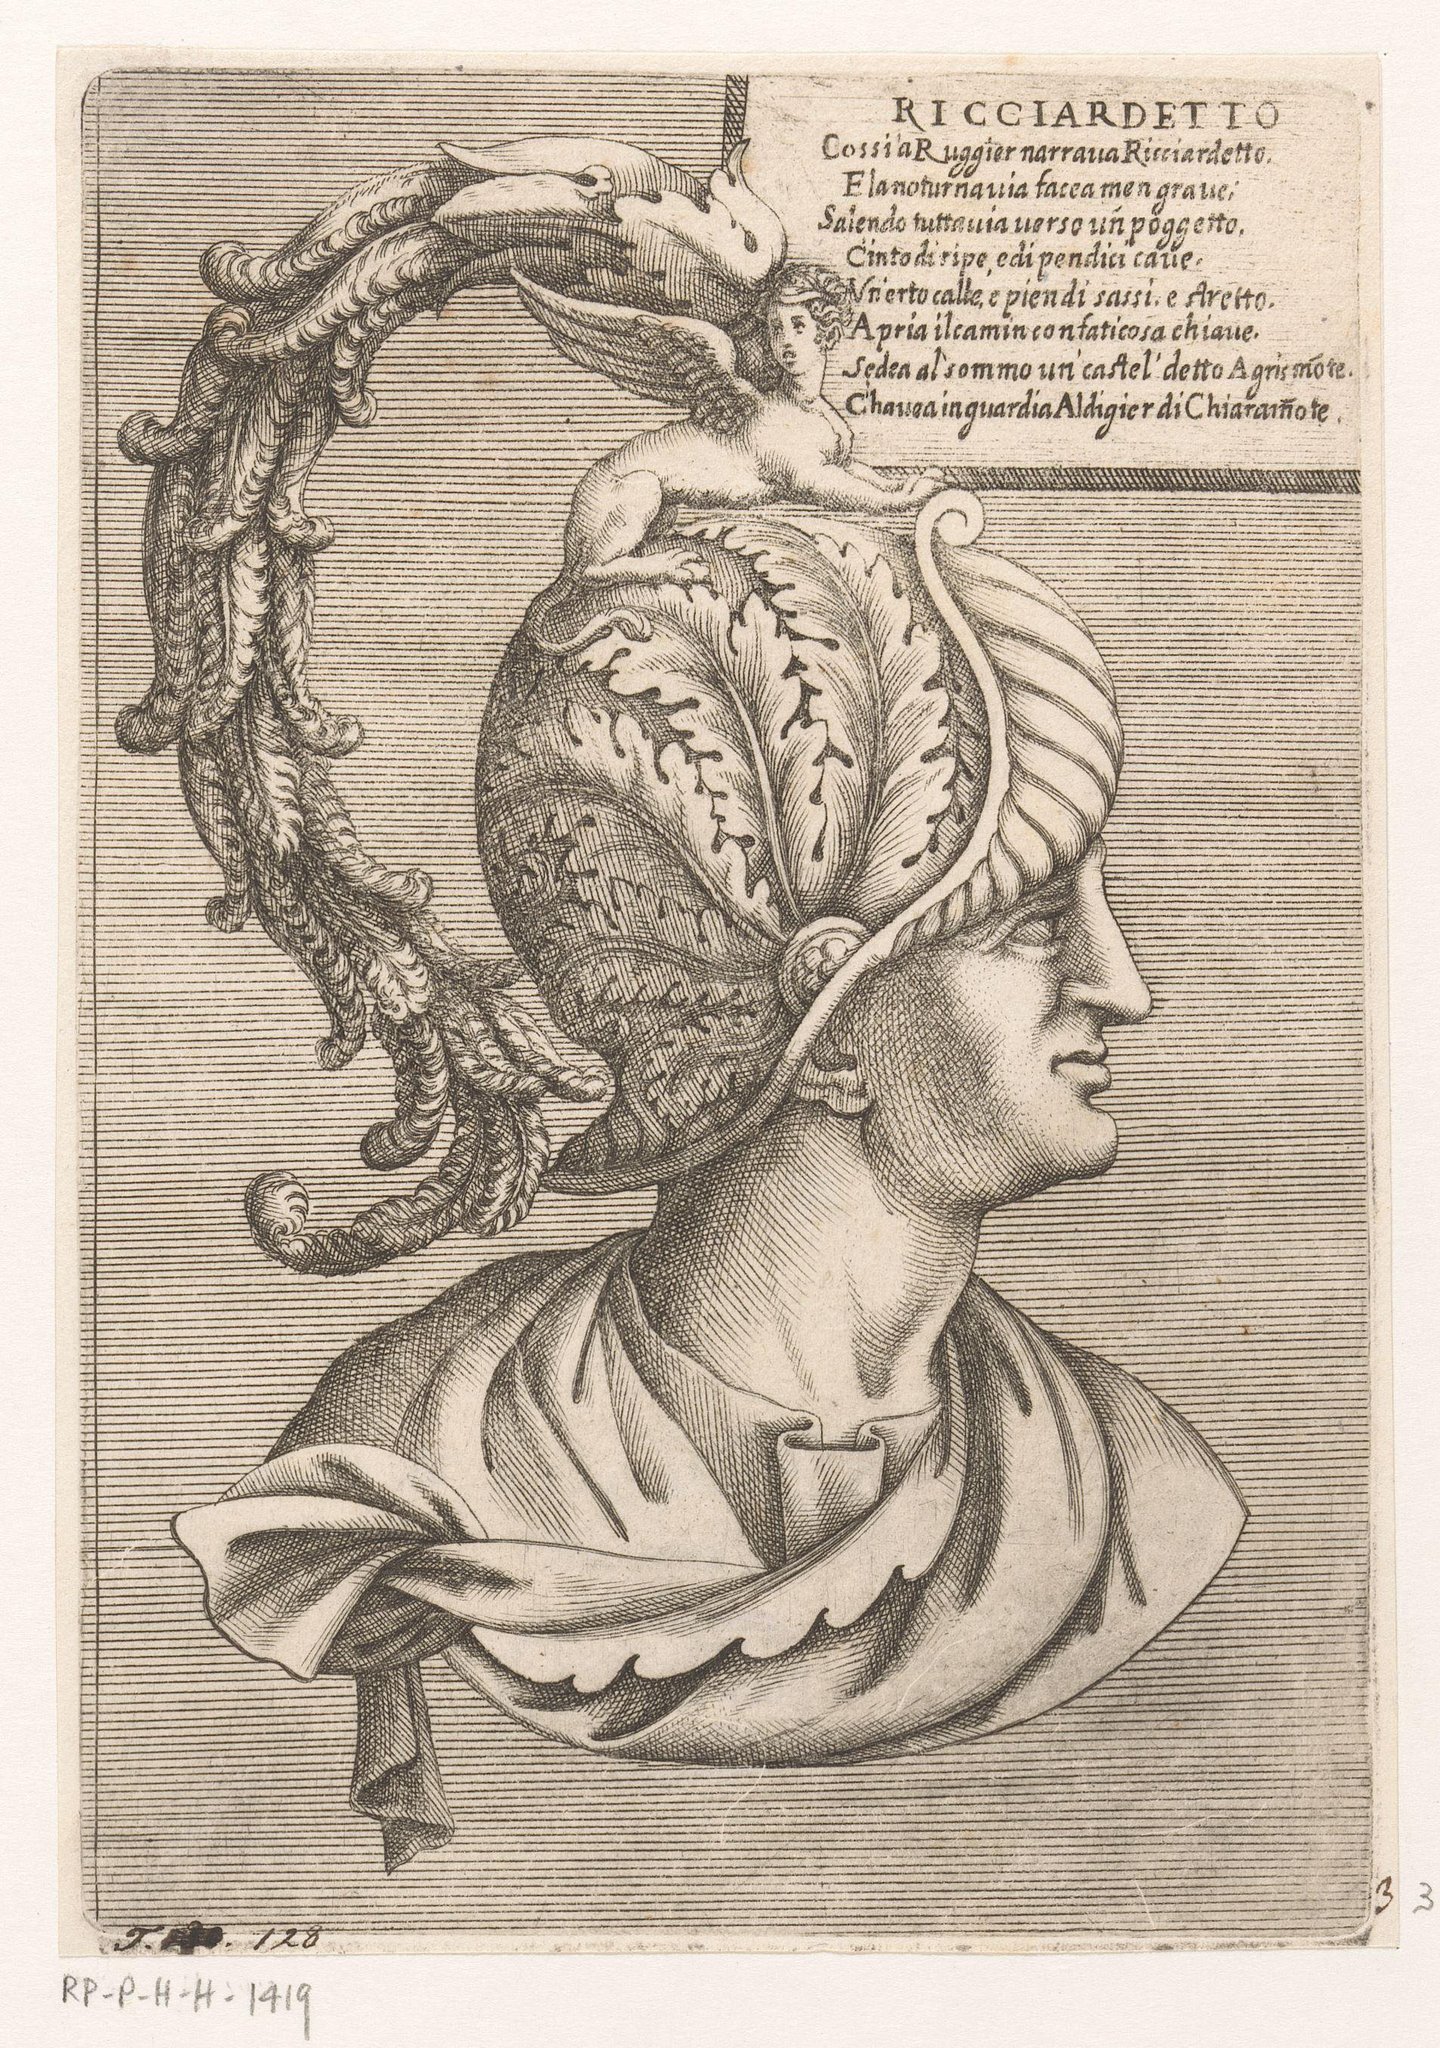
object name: print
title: Buste van Ricciardetto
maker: Anonymous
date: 1550-1599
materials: paper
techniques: engraving, etching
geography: italy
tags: helmet, sphinx (lion/woman); 'sfinge' (ripa) - aa - female human figure, male characters from 'orlando furioso' : use 82a(...)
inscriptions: number: ‘3’, collector's mark: Lugt 11, inscription: ‘T. 128’, collector's mark: Lugt 2228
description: Buste van Ricciardetto, een karakter uit Ludovico Ariosto's epos 'Orlando Furioso'. Op zijn hoofd draagt hij een helm gedecoreerd met bladeren, veren en een sfinx. Rechtsboven de titel en acht Italiaanse versregels uit het epos.